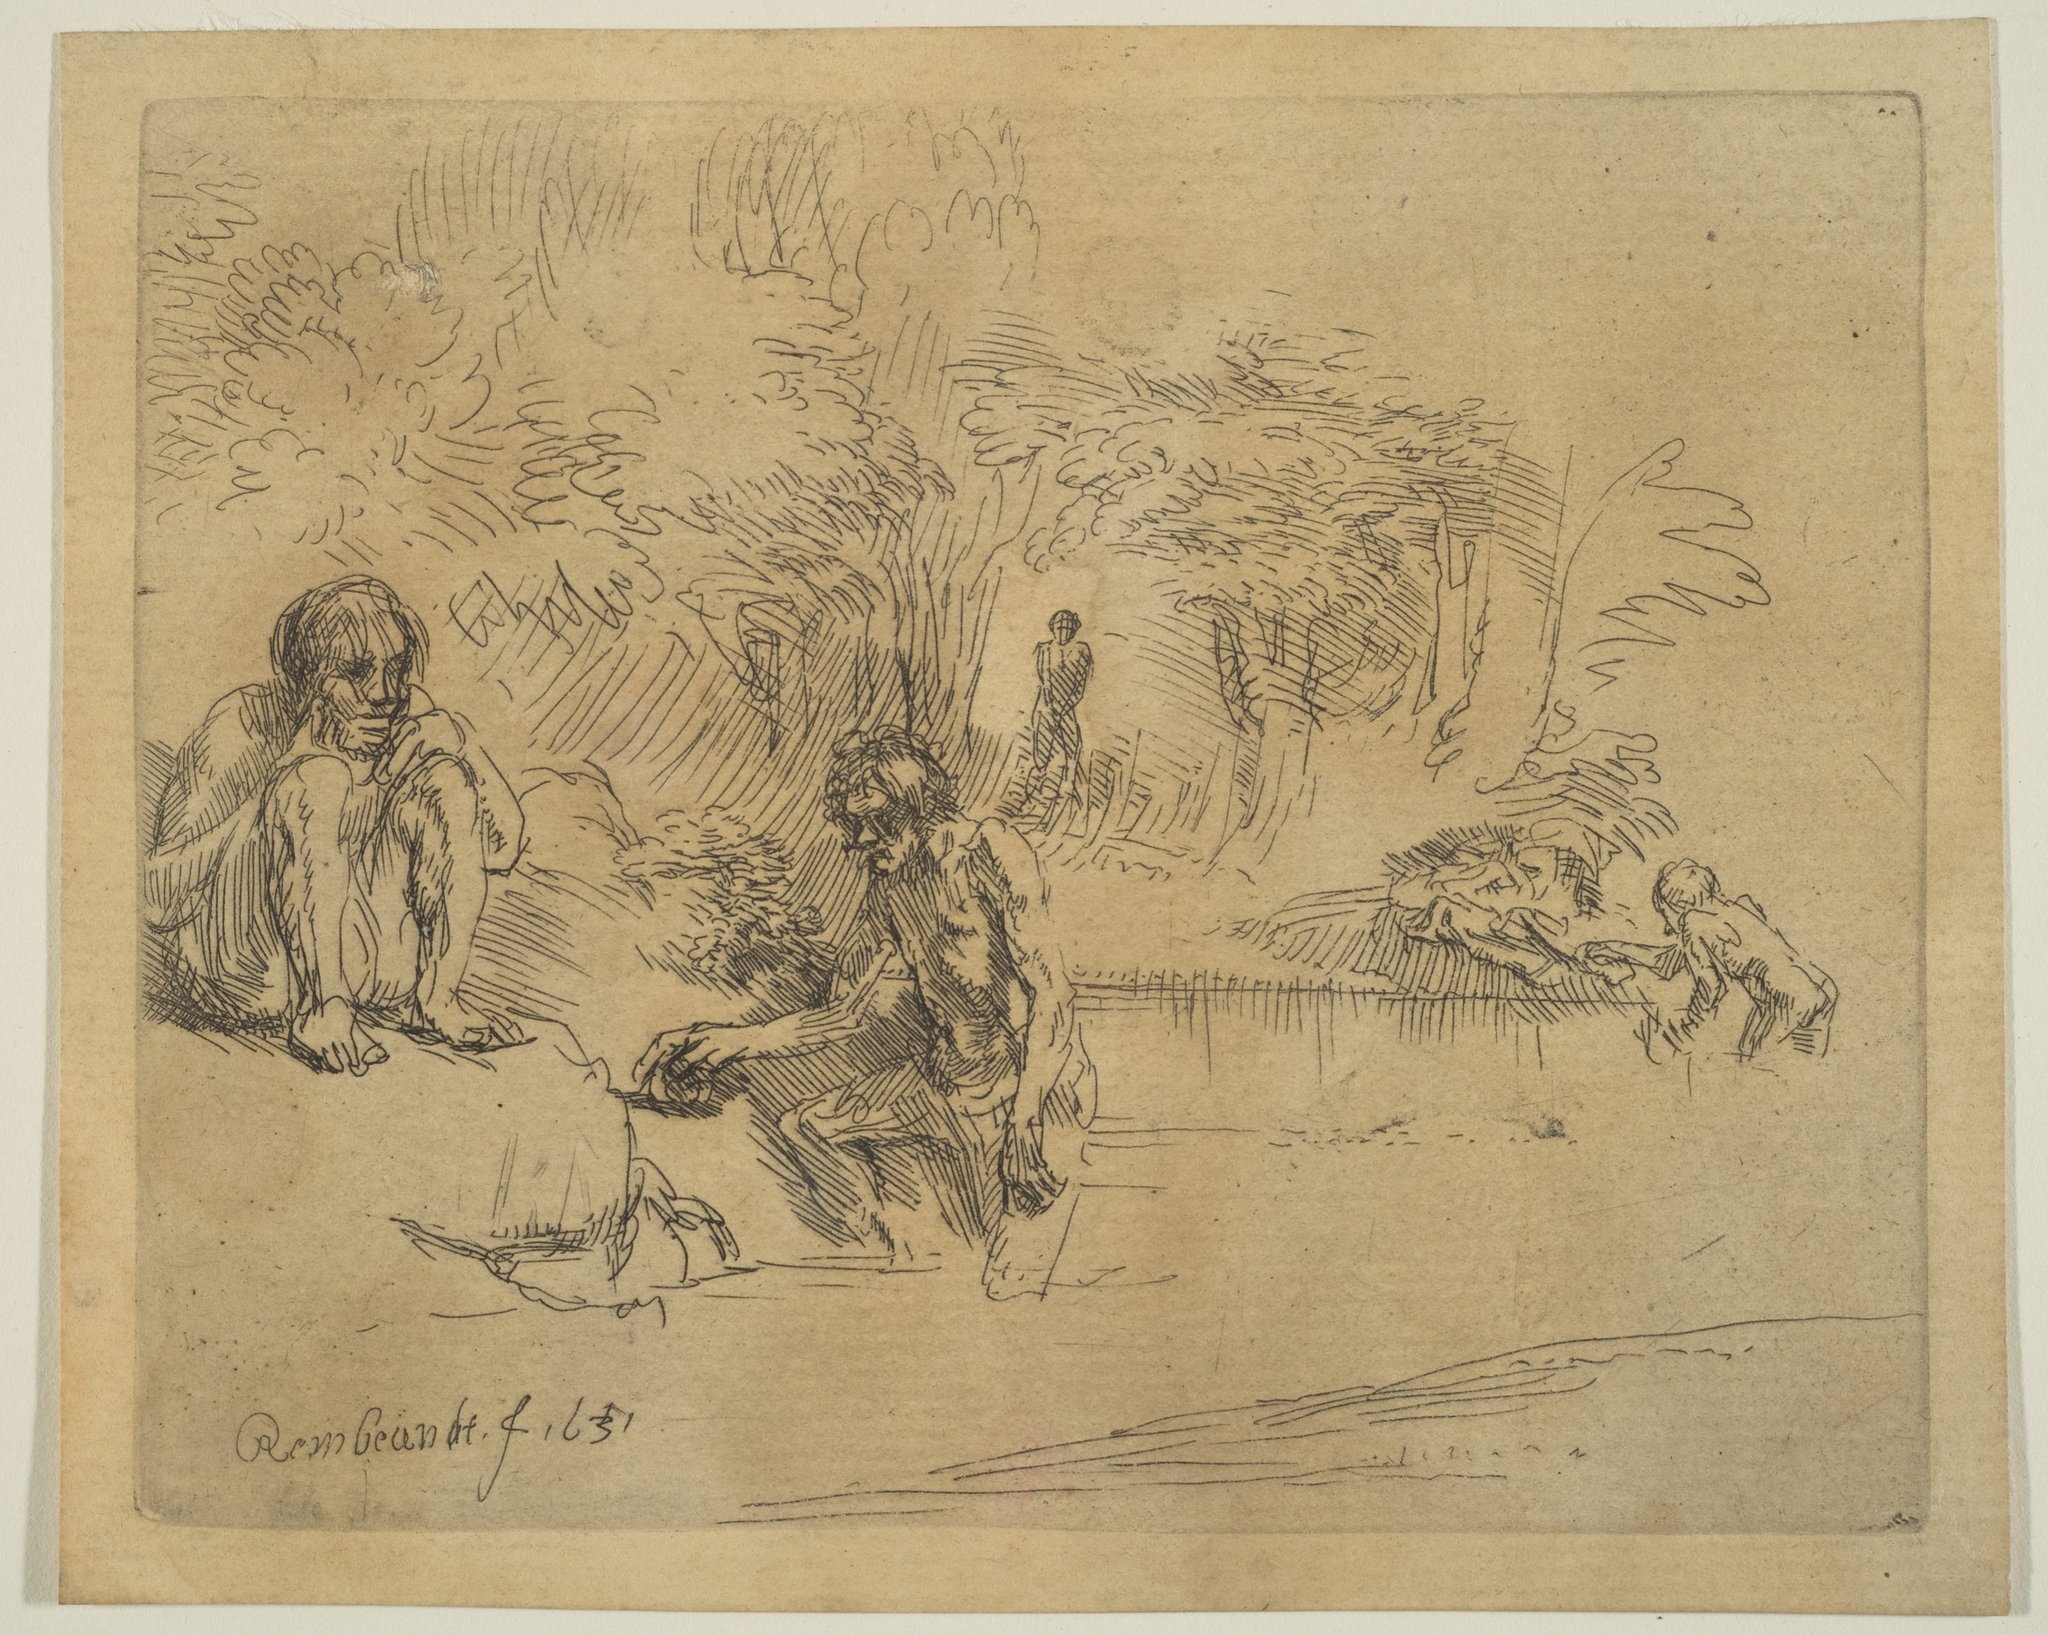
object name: print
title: The Bathers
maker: rembrandt van rijn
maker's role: artist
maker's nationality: dutch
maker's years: 1606-1669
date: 1651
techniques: etching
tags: men,bathing